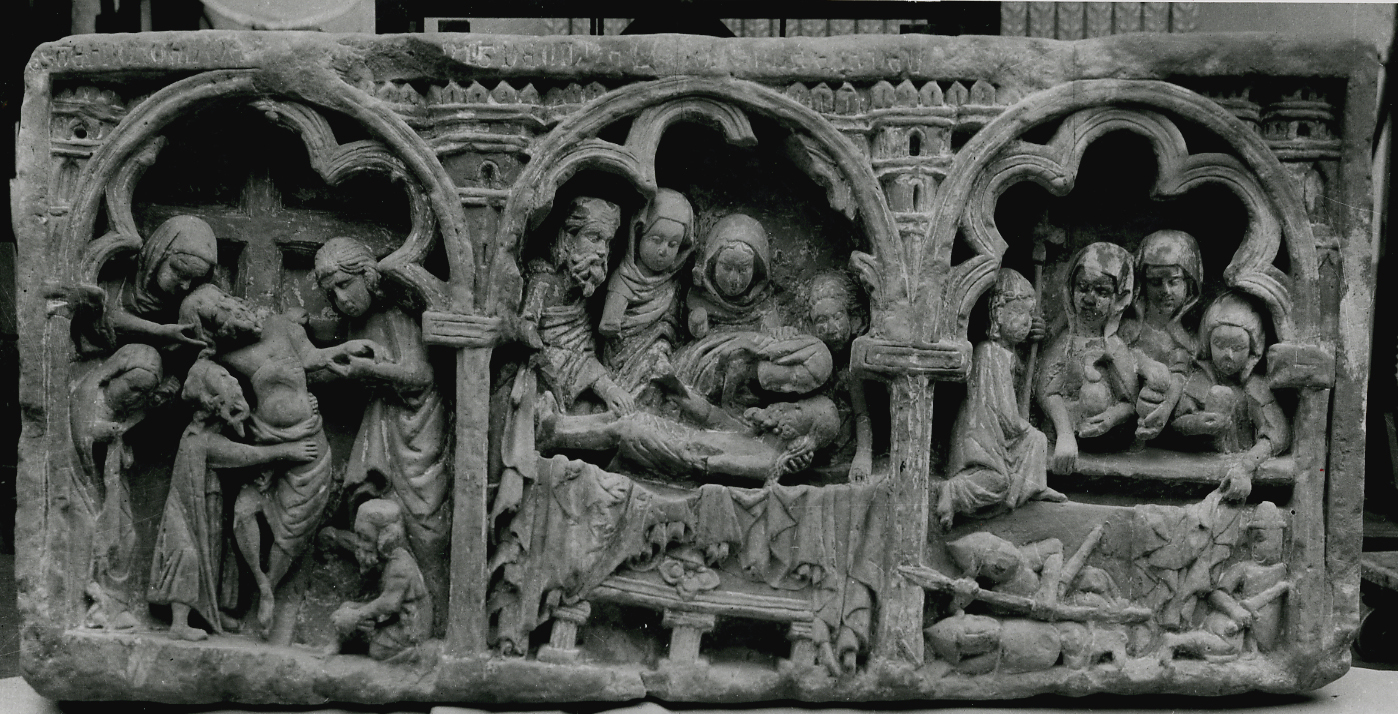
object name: relief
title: The Deposition and Burial of Christ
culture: italian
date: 1901-1933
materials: stone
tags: men,women,christ,descent from the cross,entombment